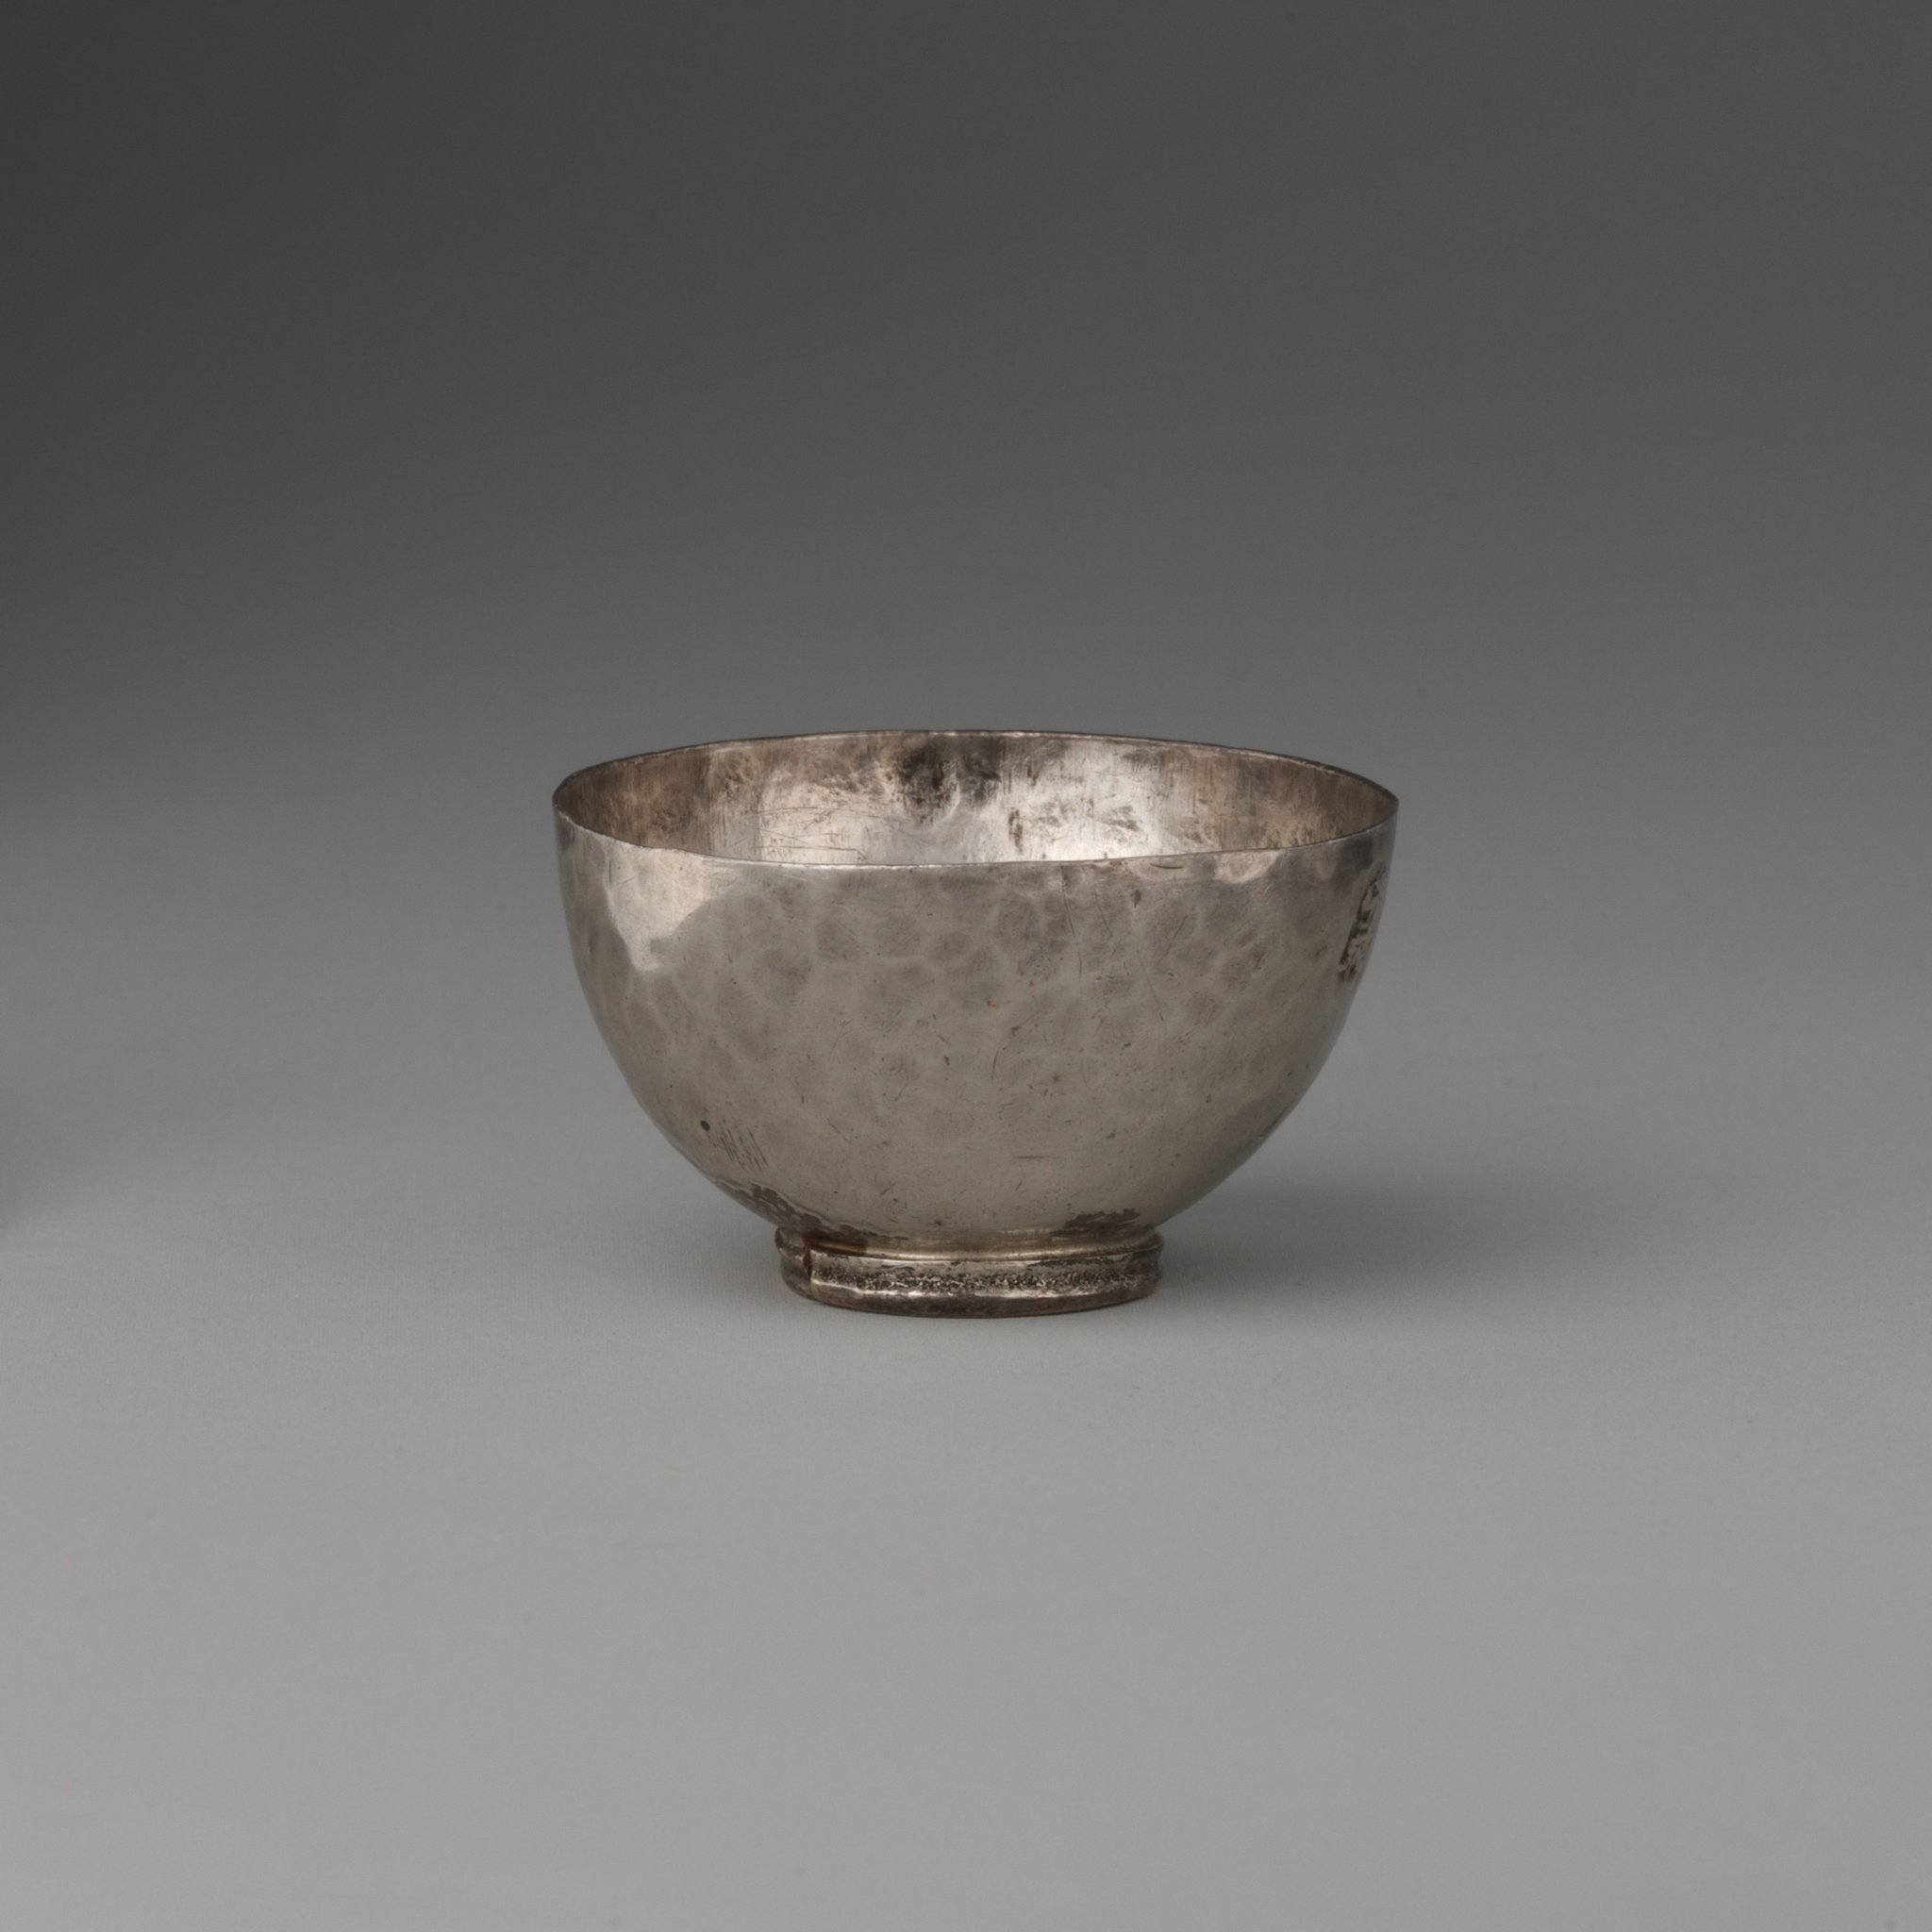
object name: waste bowl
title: Miniature waste bowl (part of a set)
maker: david clayton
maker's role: maker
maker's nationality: british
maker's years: 1659-1719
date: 1667-1733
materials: silver